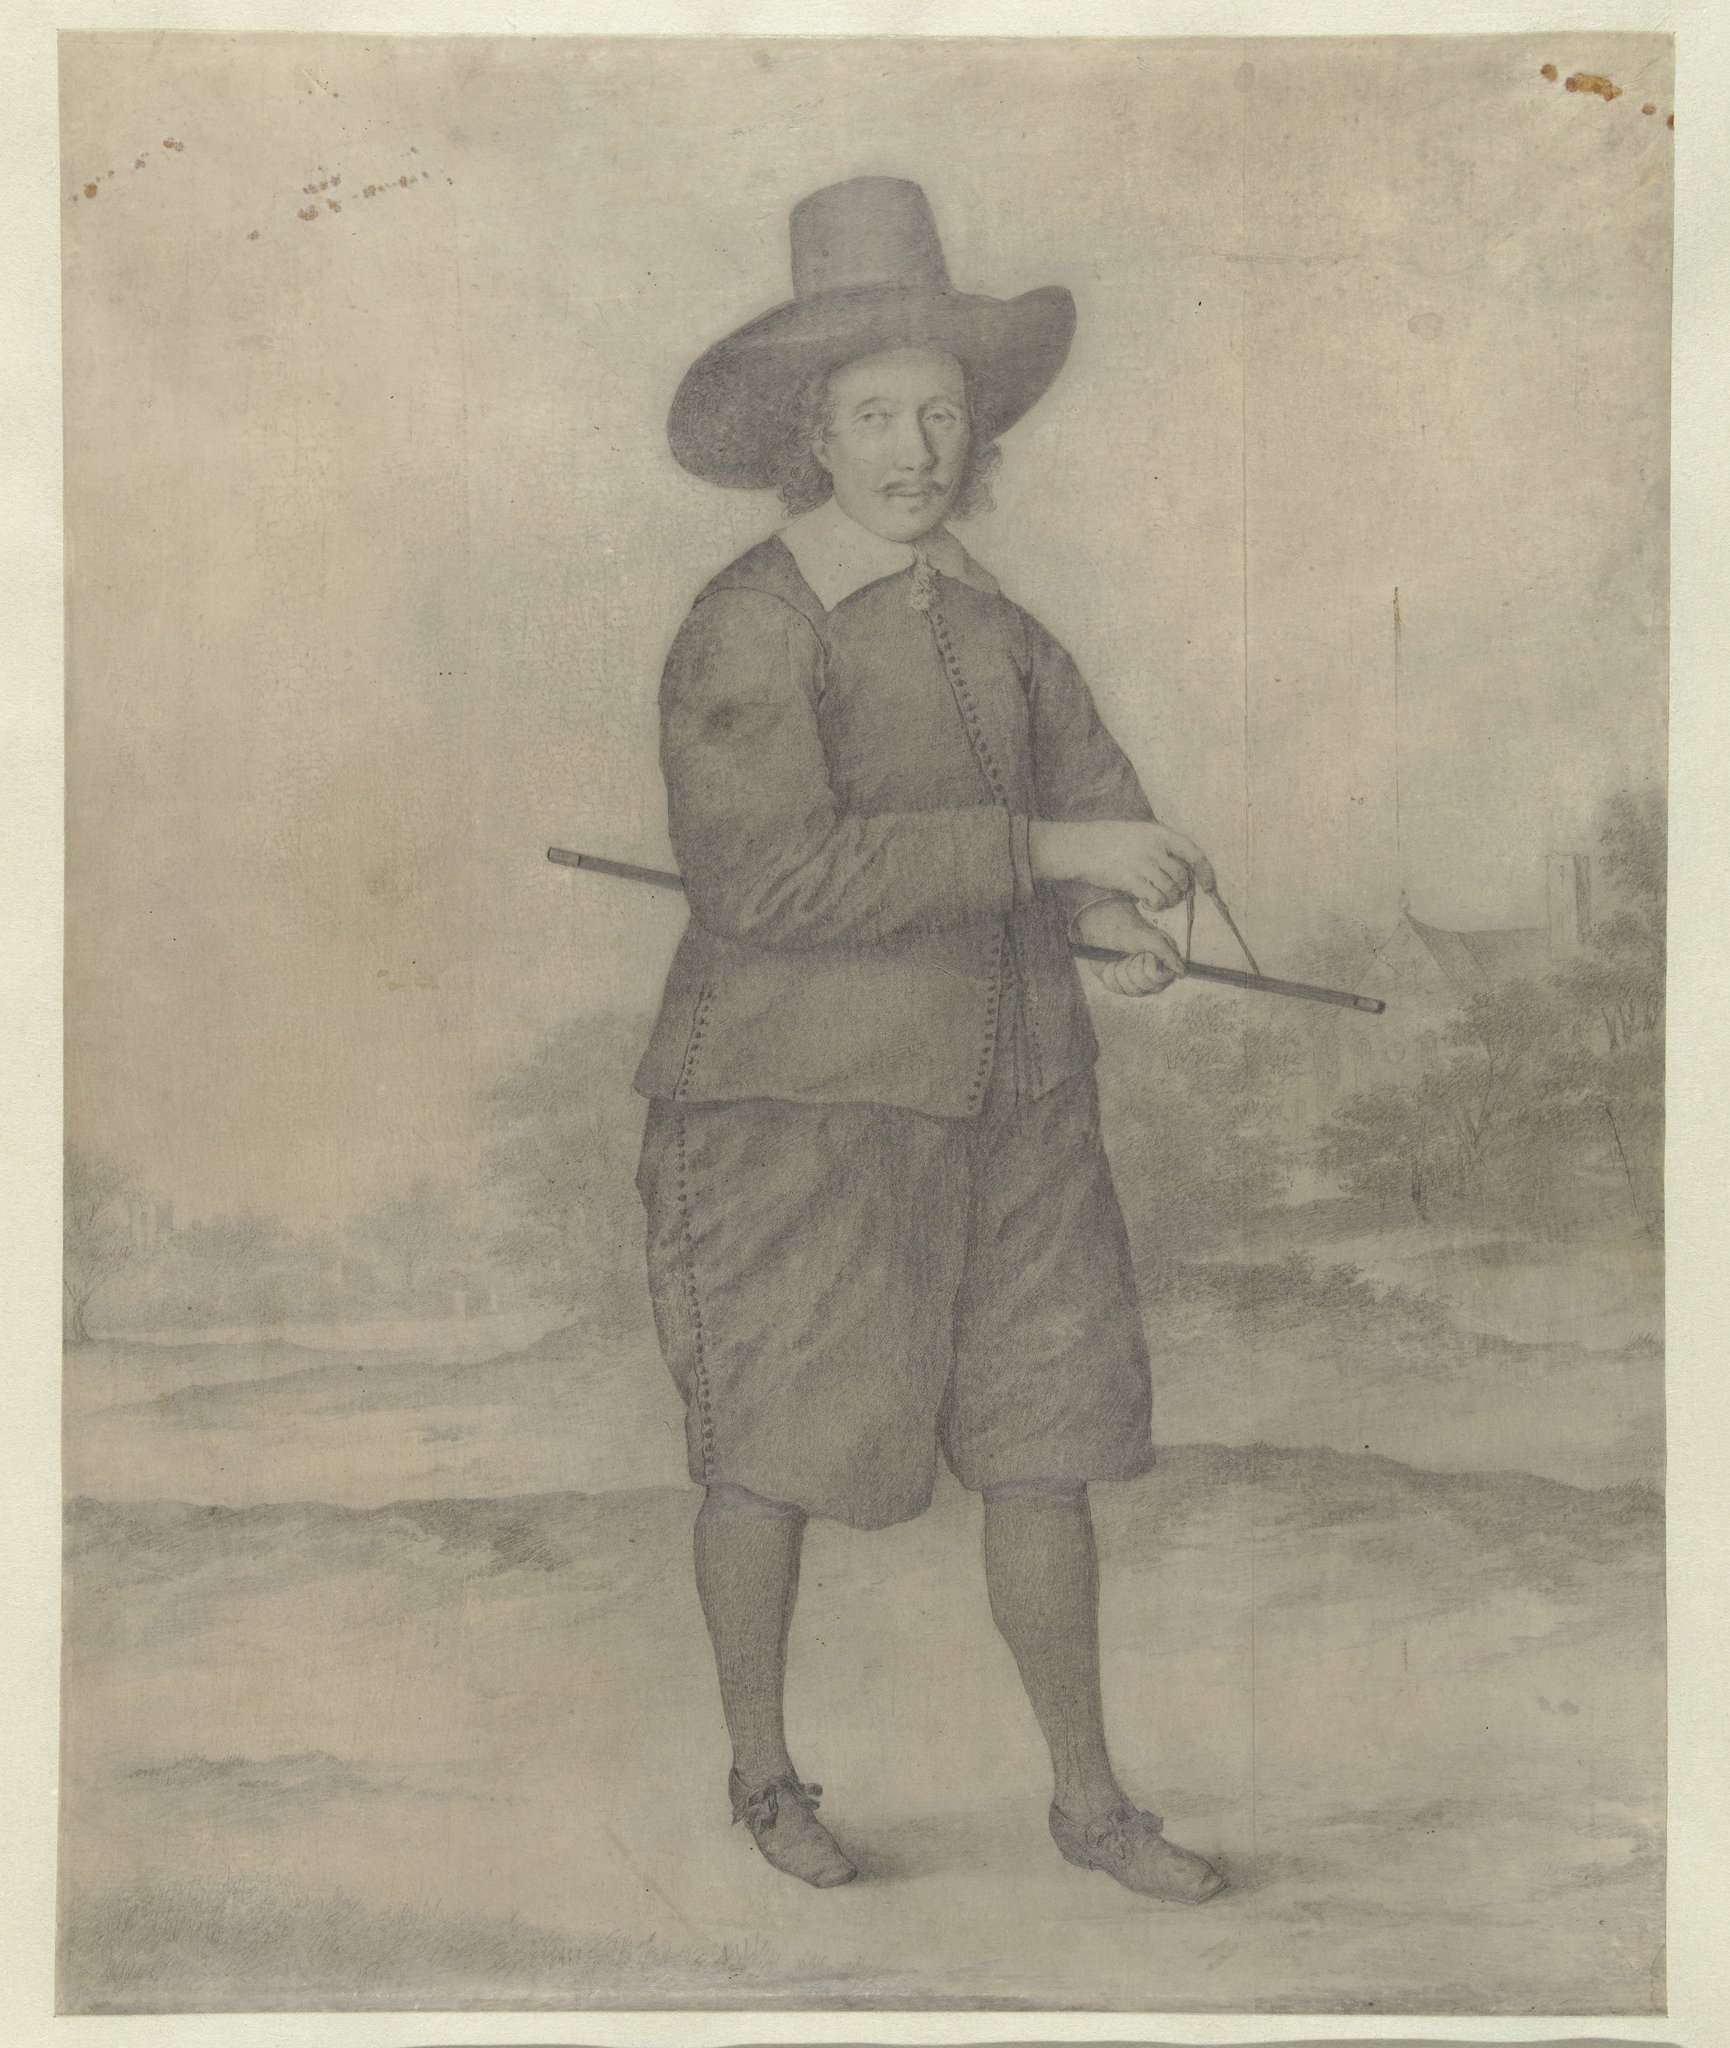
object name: drawing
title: Staande man met breedgerande hoed, ten voeten uit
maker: Anonymous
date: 1600-1699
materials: parchment, pencil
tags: anonymous historical person portrayed alone